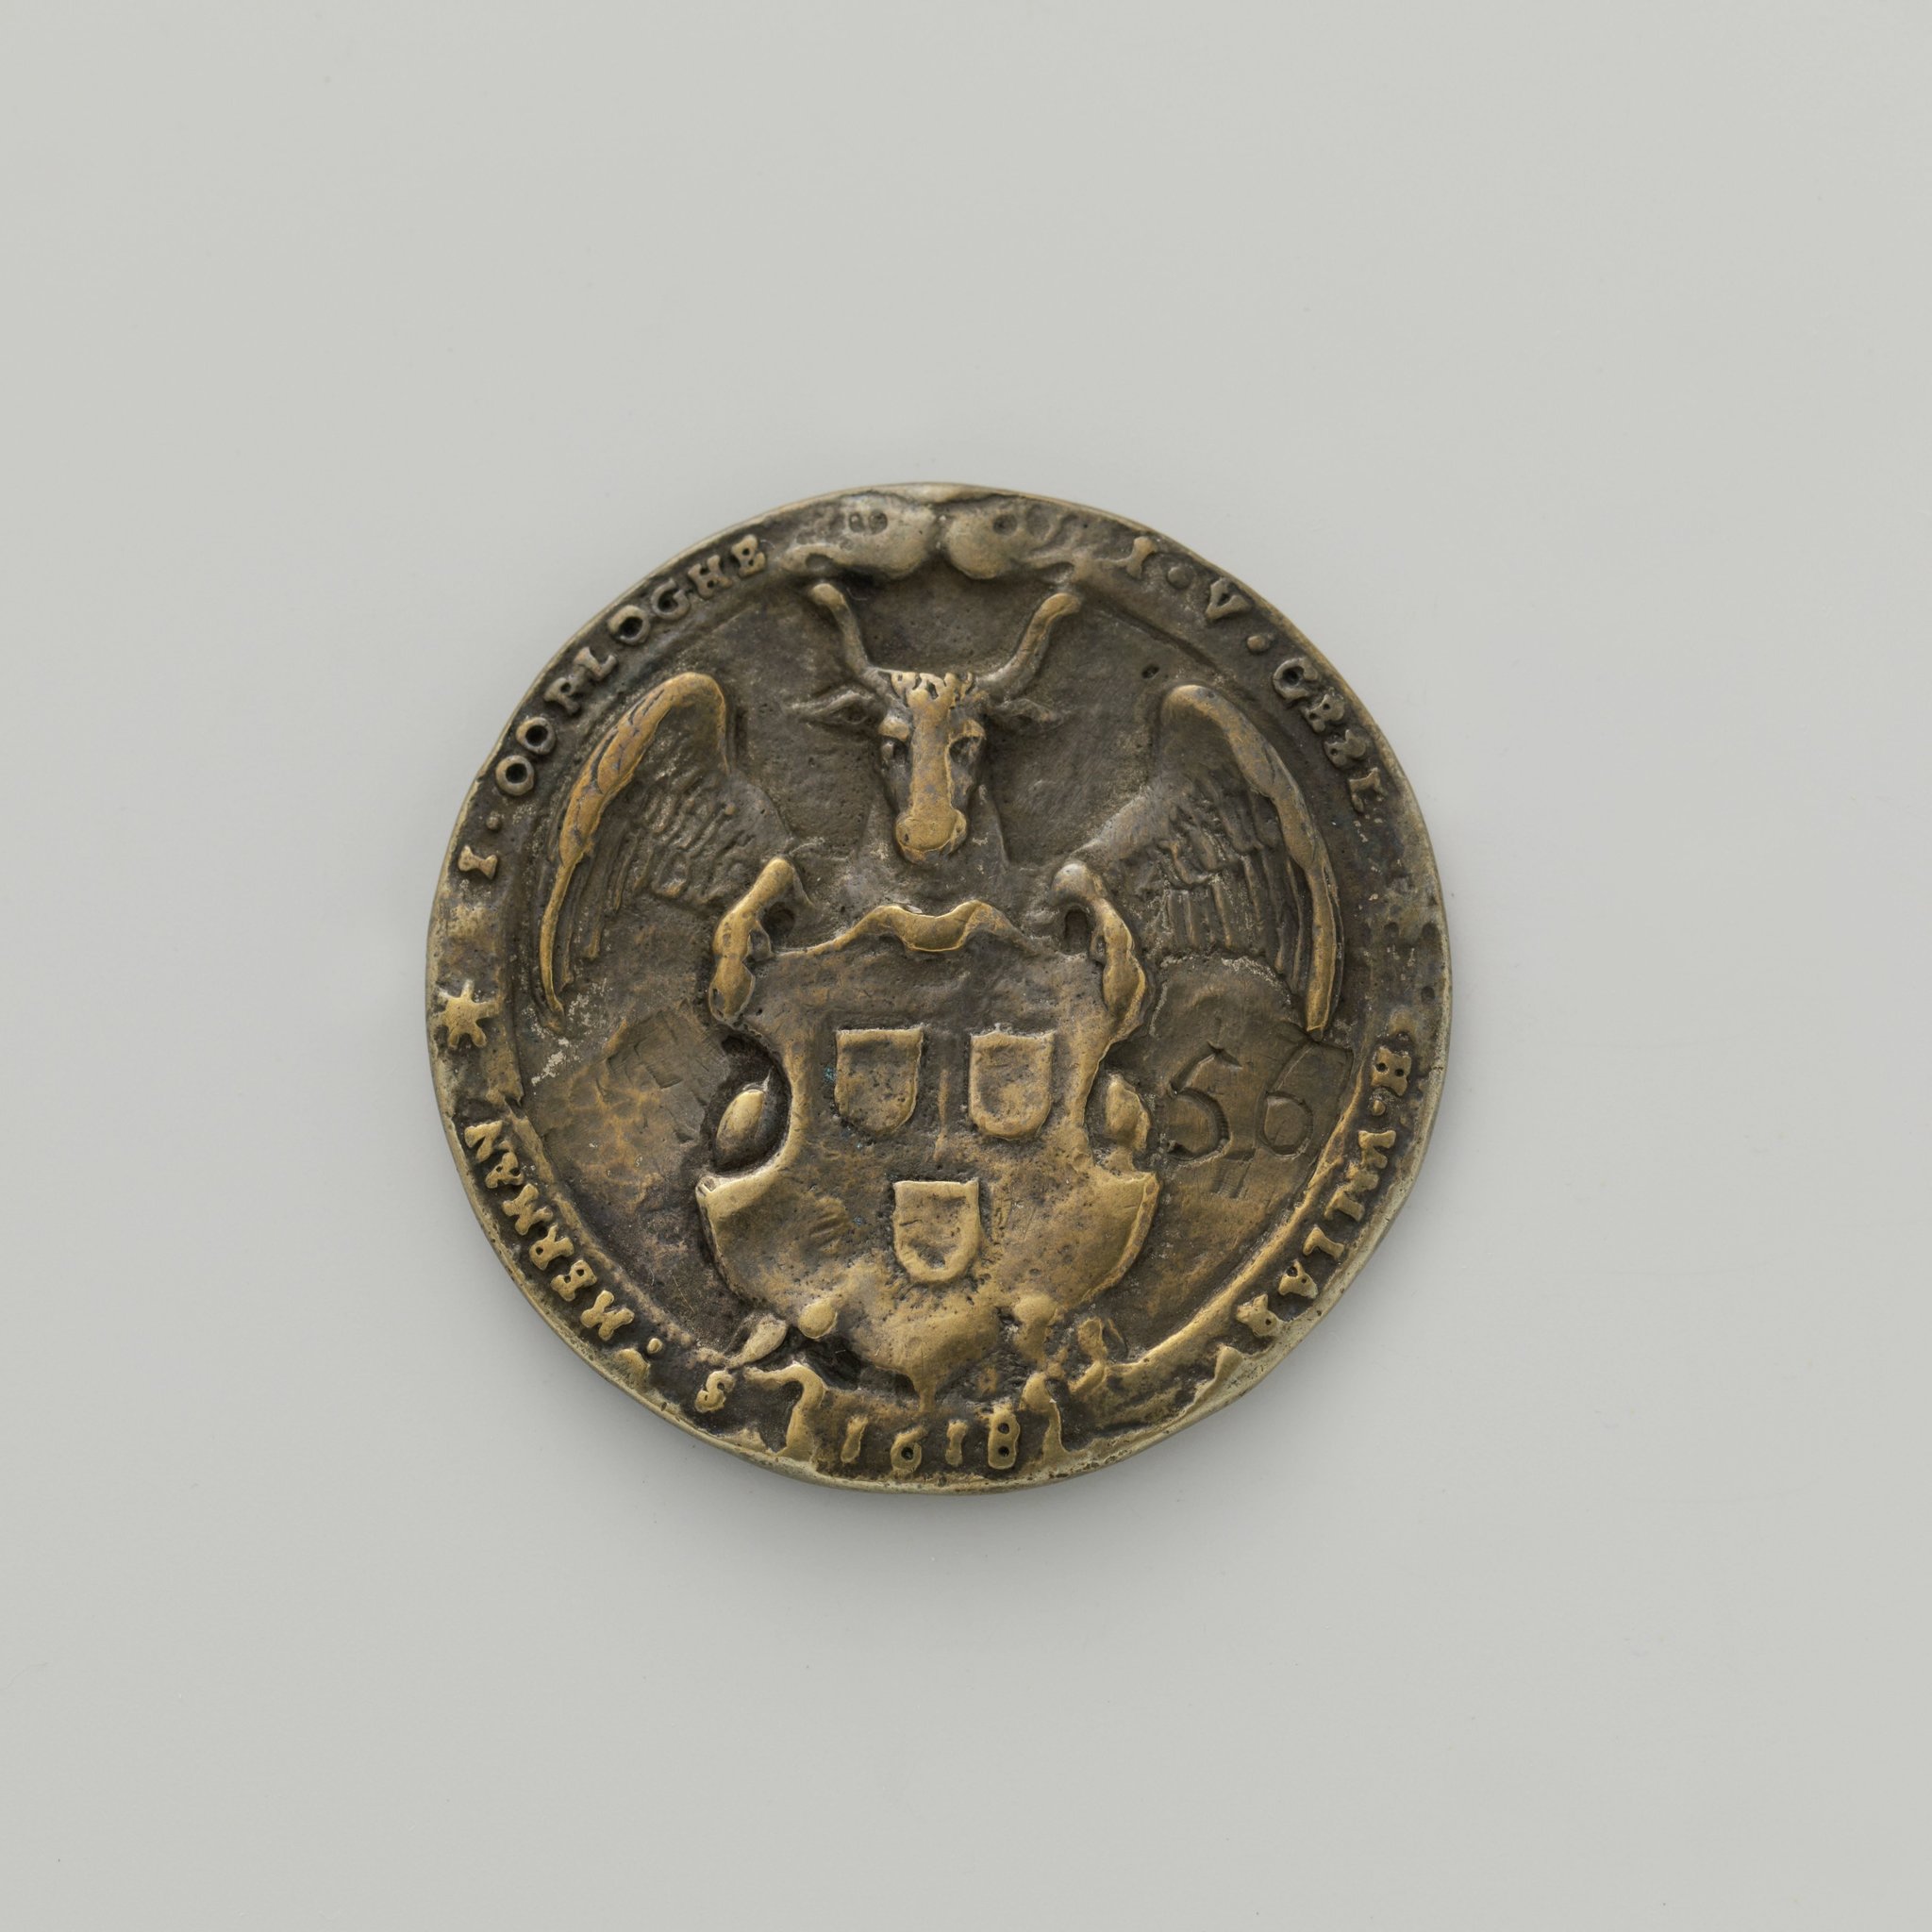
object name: medal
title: Guild of St Luke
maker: adriaen pietersz van de venne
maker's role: draughtsman, painter, print maker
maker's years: 1589-1662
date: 1618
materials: brass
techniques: casting, engraving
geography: middelburg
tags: middelburg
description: Guild medals Members of trade guilds had to identify themselves with a medal at their meetings.